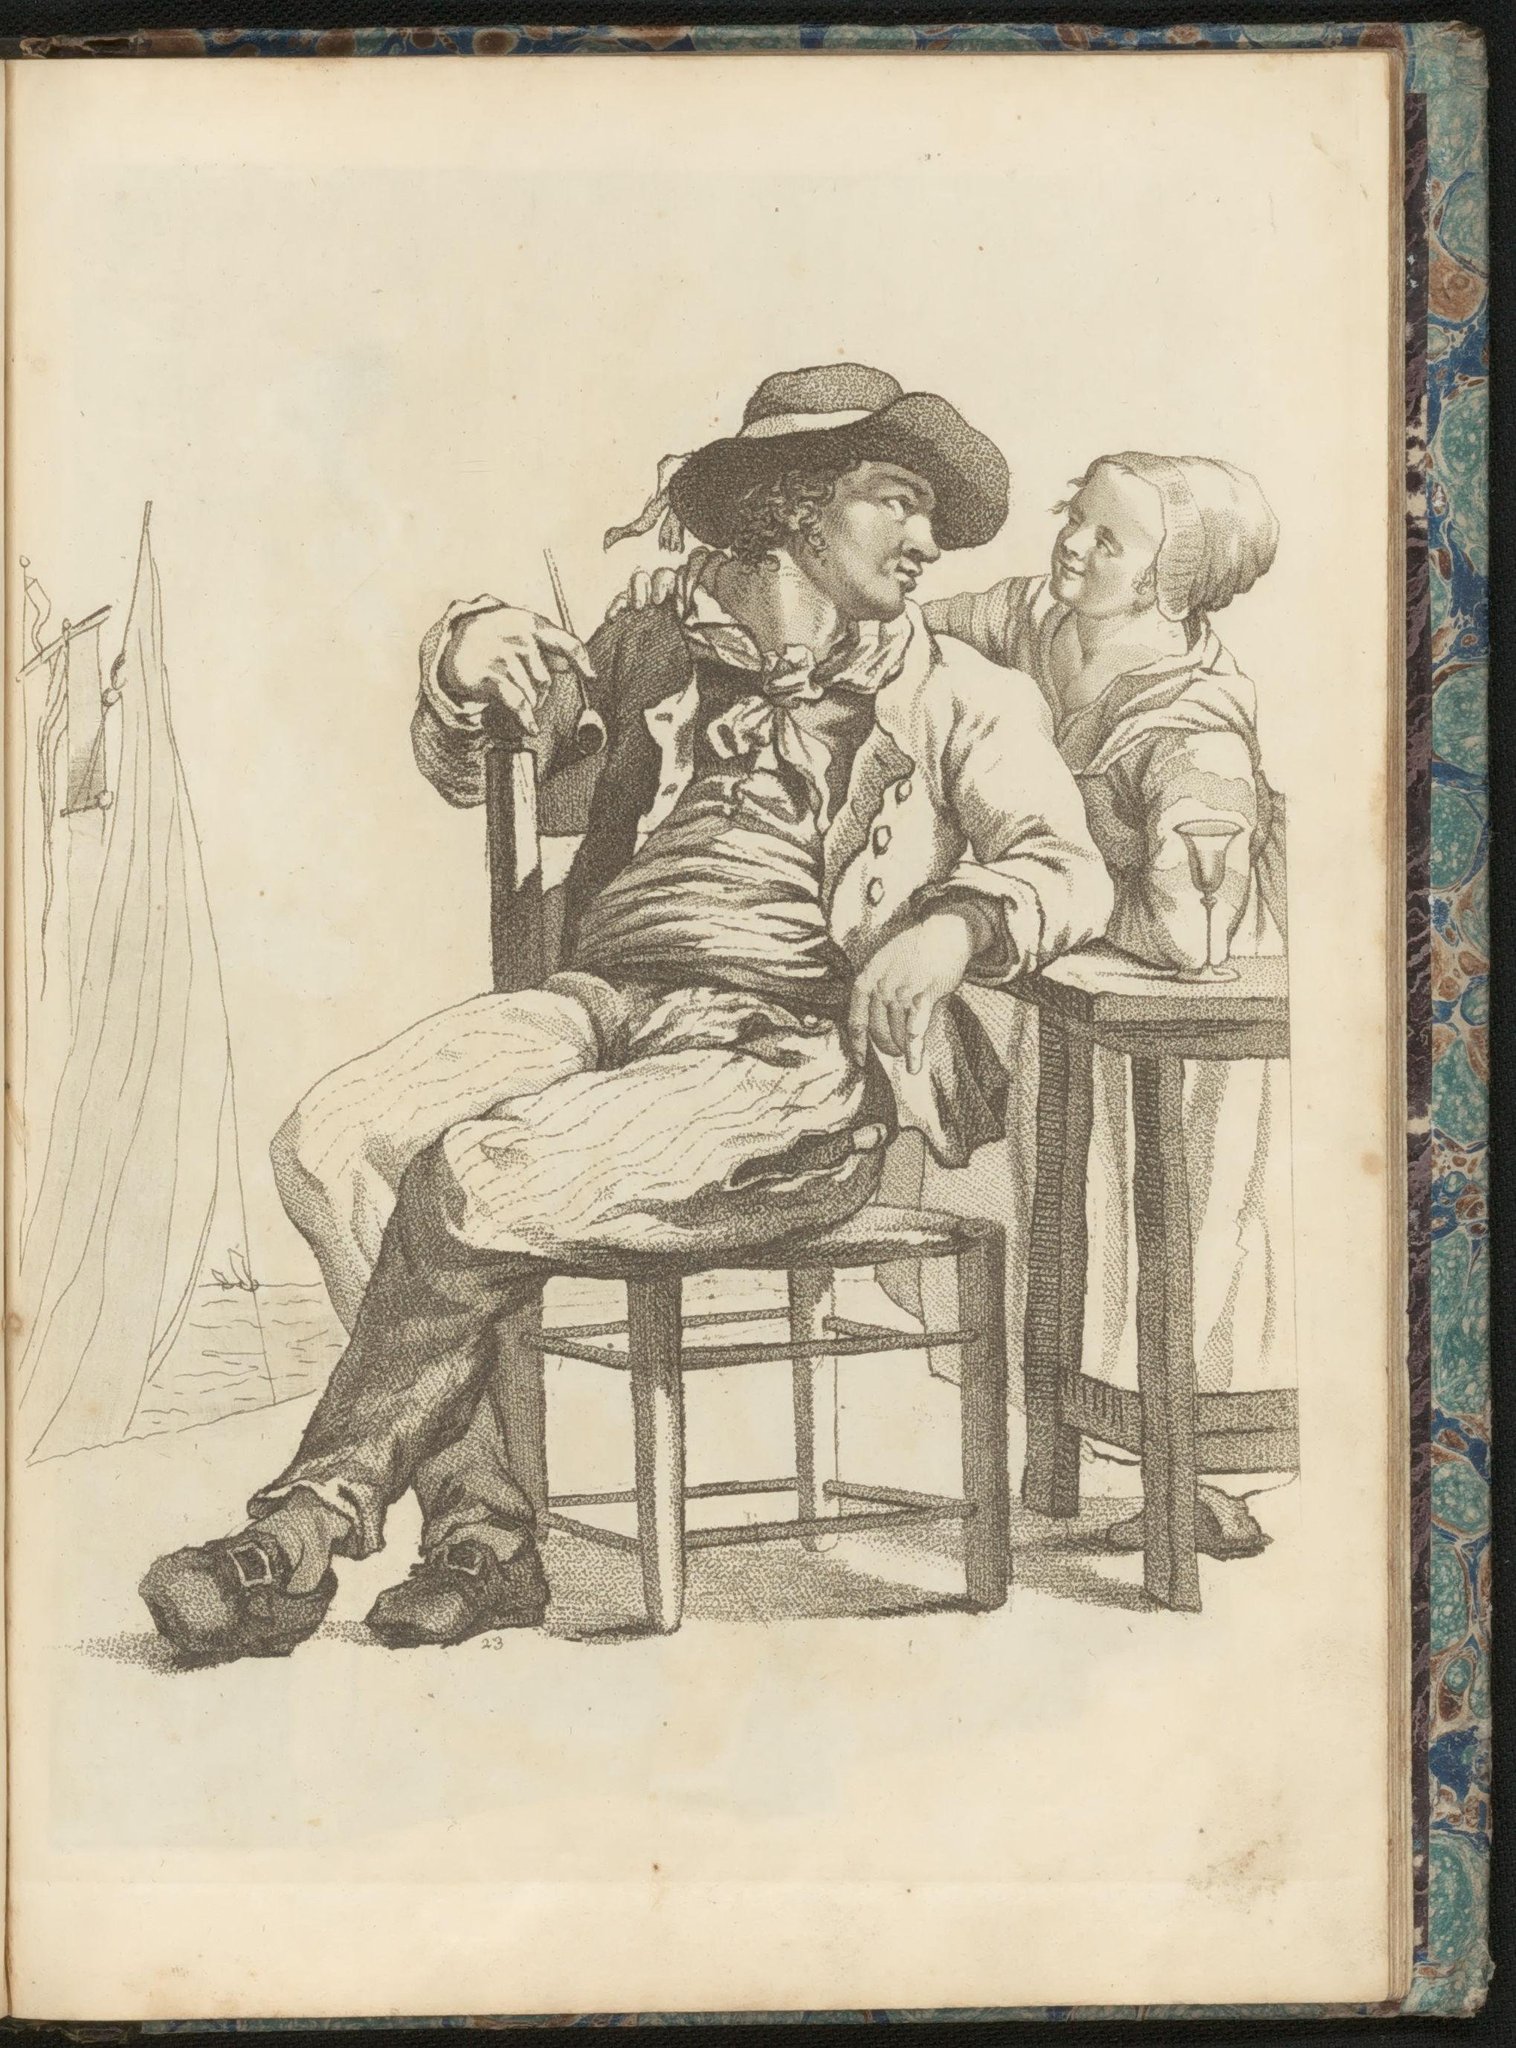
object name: print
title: Zeeman in gesprek met een jonge vrouw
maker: mathias de sallieth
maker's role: print maker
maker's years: 1749-1791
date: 1772-1791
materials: paper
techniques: aquatint, printmaking, etching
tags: adolescent, young woman, maiden, sailor, conversation, dialogue; conversation piece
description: De prent verscheen vanaf 1818 tevens als onderdeel van een 33-delige reeks prenten door Mathias de Sallieth, samengebonden in: Perkois, Jacobus, Prins, Johannes Huibert. Verzameling van verschillende gekleede mans- en vrouwenstanden, ter oefening van jonge schilders en liefhebbers. Rotterdam: Johannes Immerzeel, 1818. Alle verso-bladen uit dit prentalbum zijn blanco.